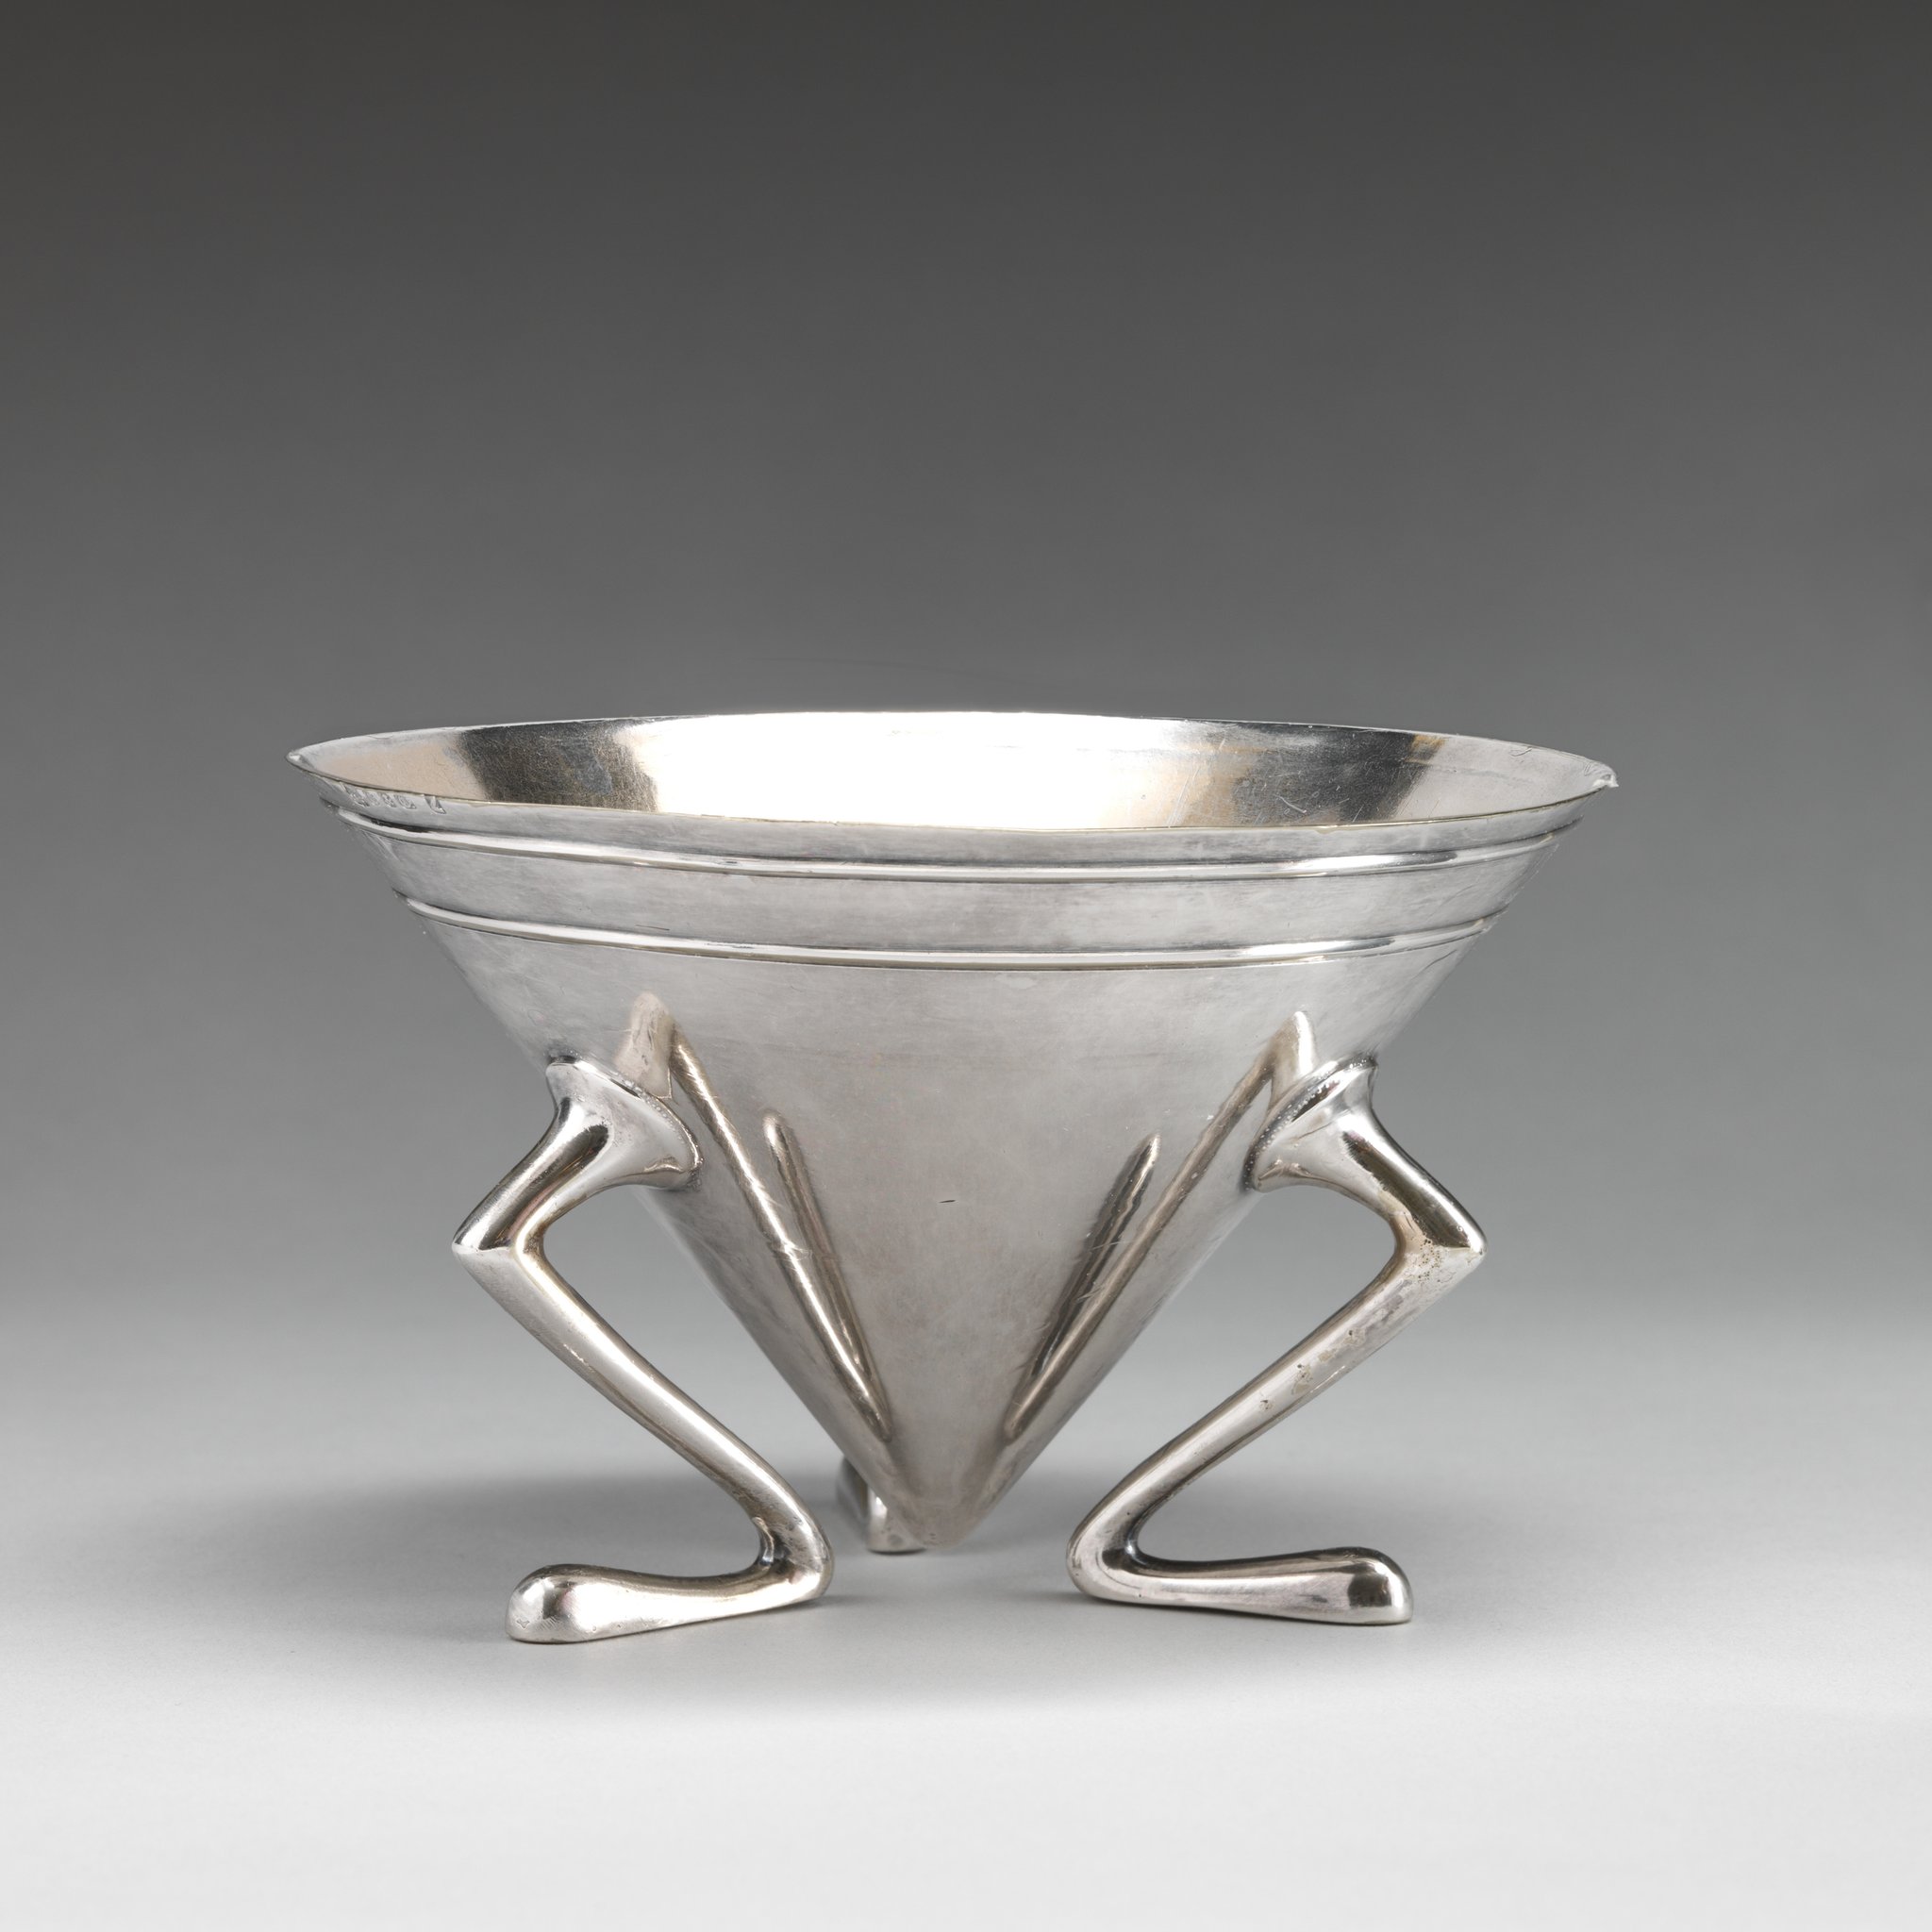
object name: sugar bowl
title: Sugar bowl (Model 247)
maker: christopher dresser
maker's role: designer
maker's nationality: british, scottish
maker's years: 1834-1904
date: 1885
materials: nickel, silver